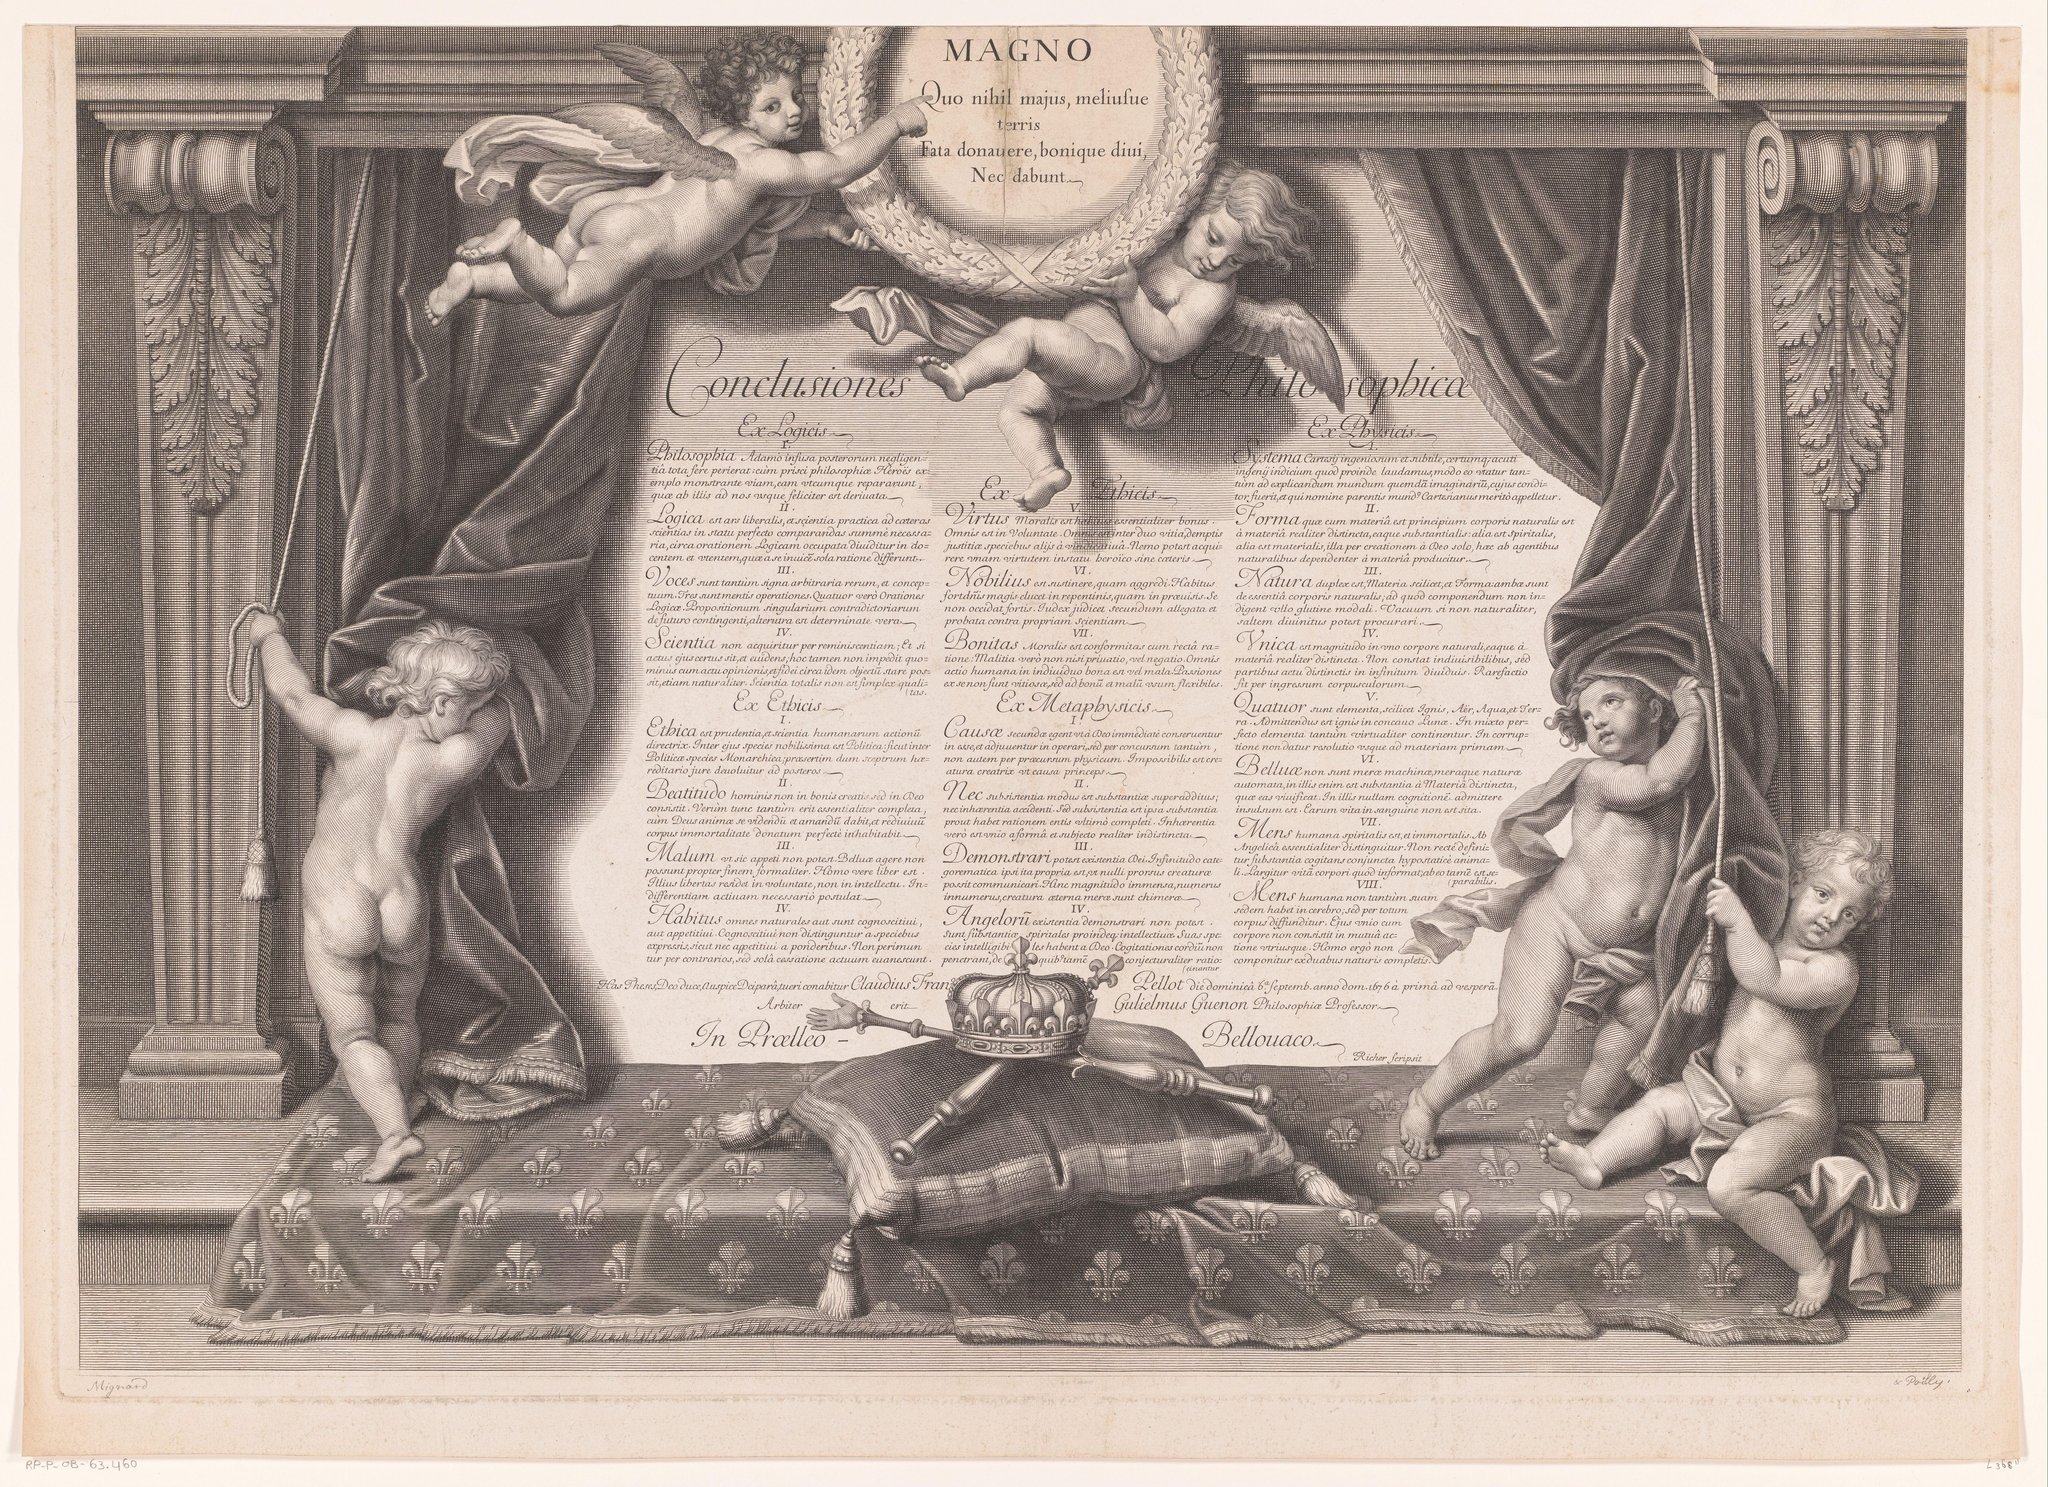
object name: print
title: Allegorisch portret van Lodewijk XIV (onderste deel)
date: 1676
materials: paper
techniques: engraving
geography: france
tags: lodewijk xiv (koning van frankrijk), official; civil servant; functionary (in general), historical persons, cupids: 'amores', 'amoretti', 'putti', king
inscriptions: collector's mark: Lugt 240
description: These van Claude-François Pellot opgedragen aan Lodewijk XIV. Putti openen het gordijn dat voor de tekst van de these hangt.